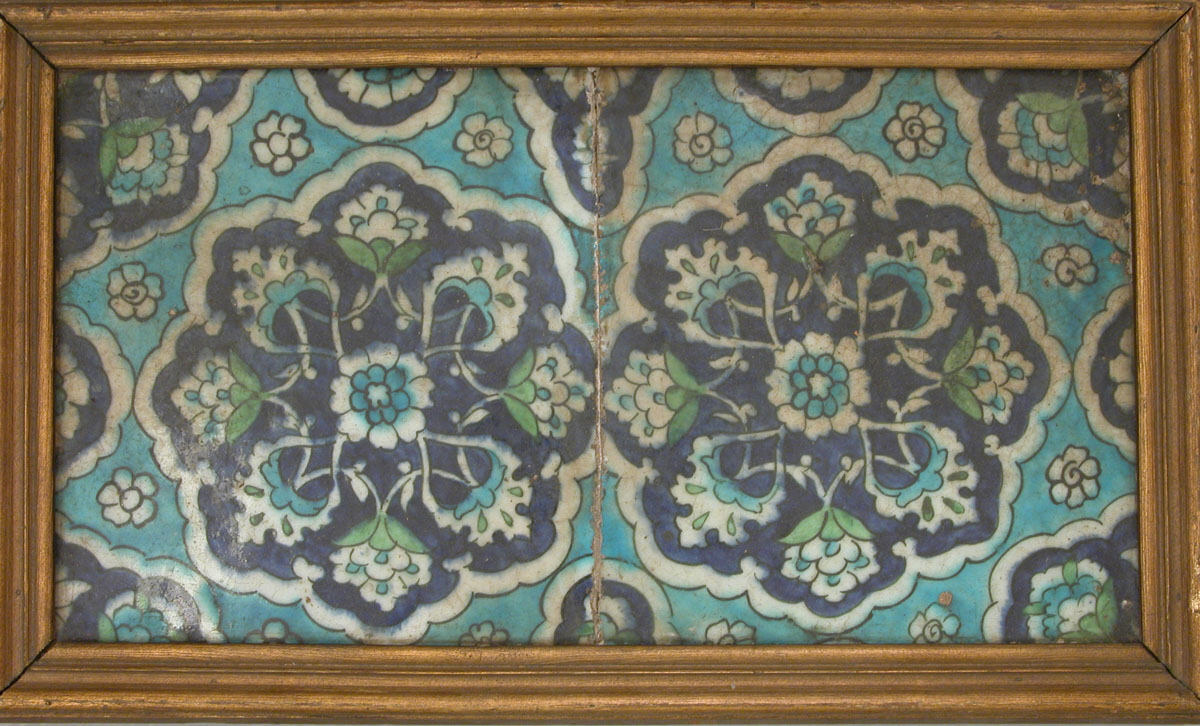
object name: tile panel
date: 1601-1650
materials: stonepaste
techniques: glazing, painting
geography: syria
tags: flowers